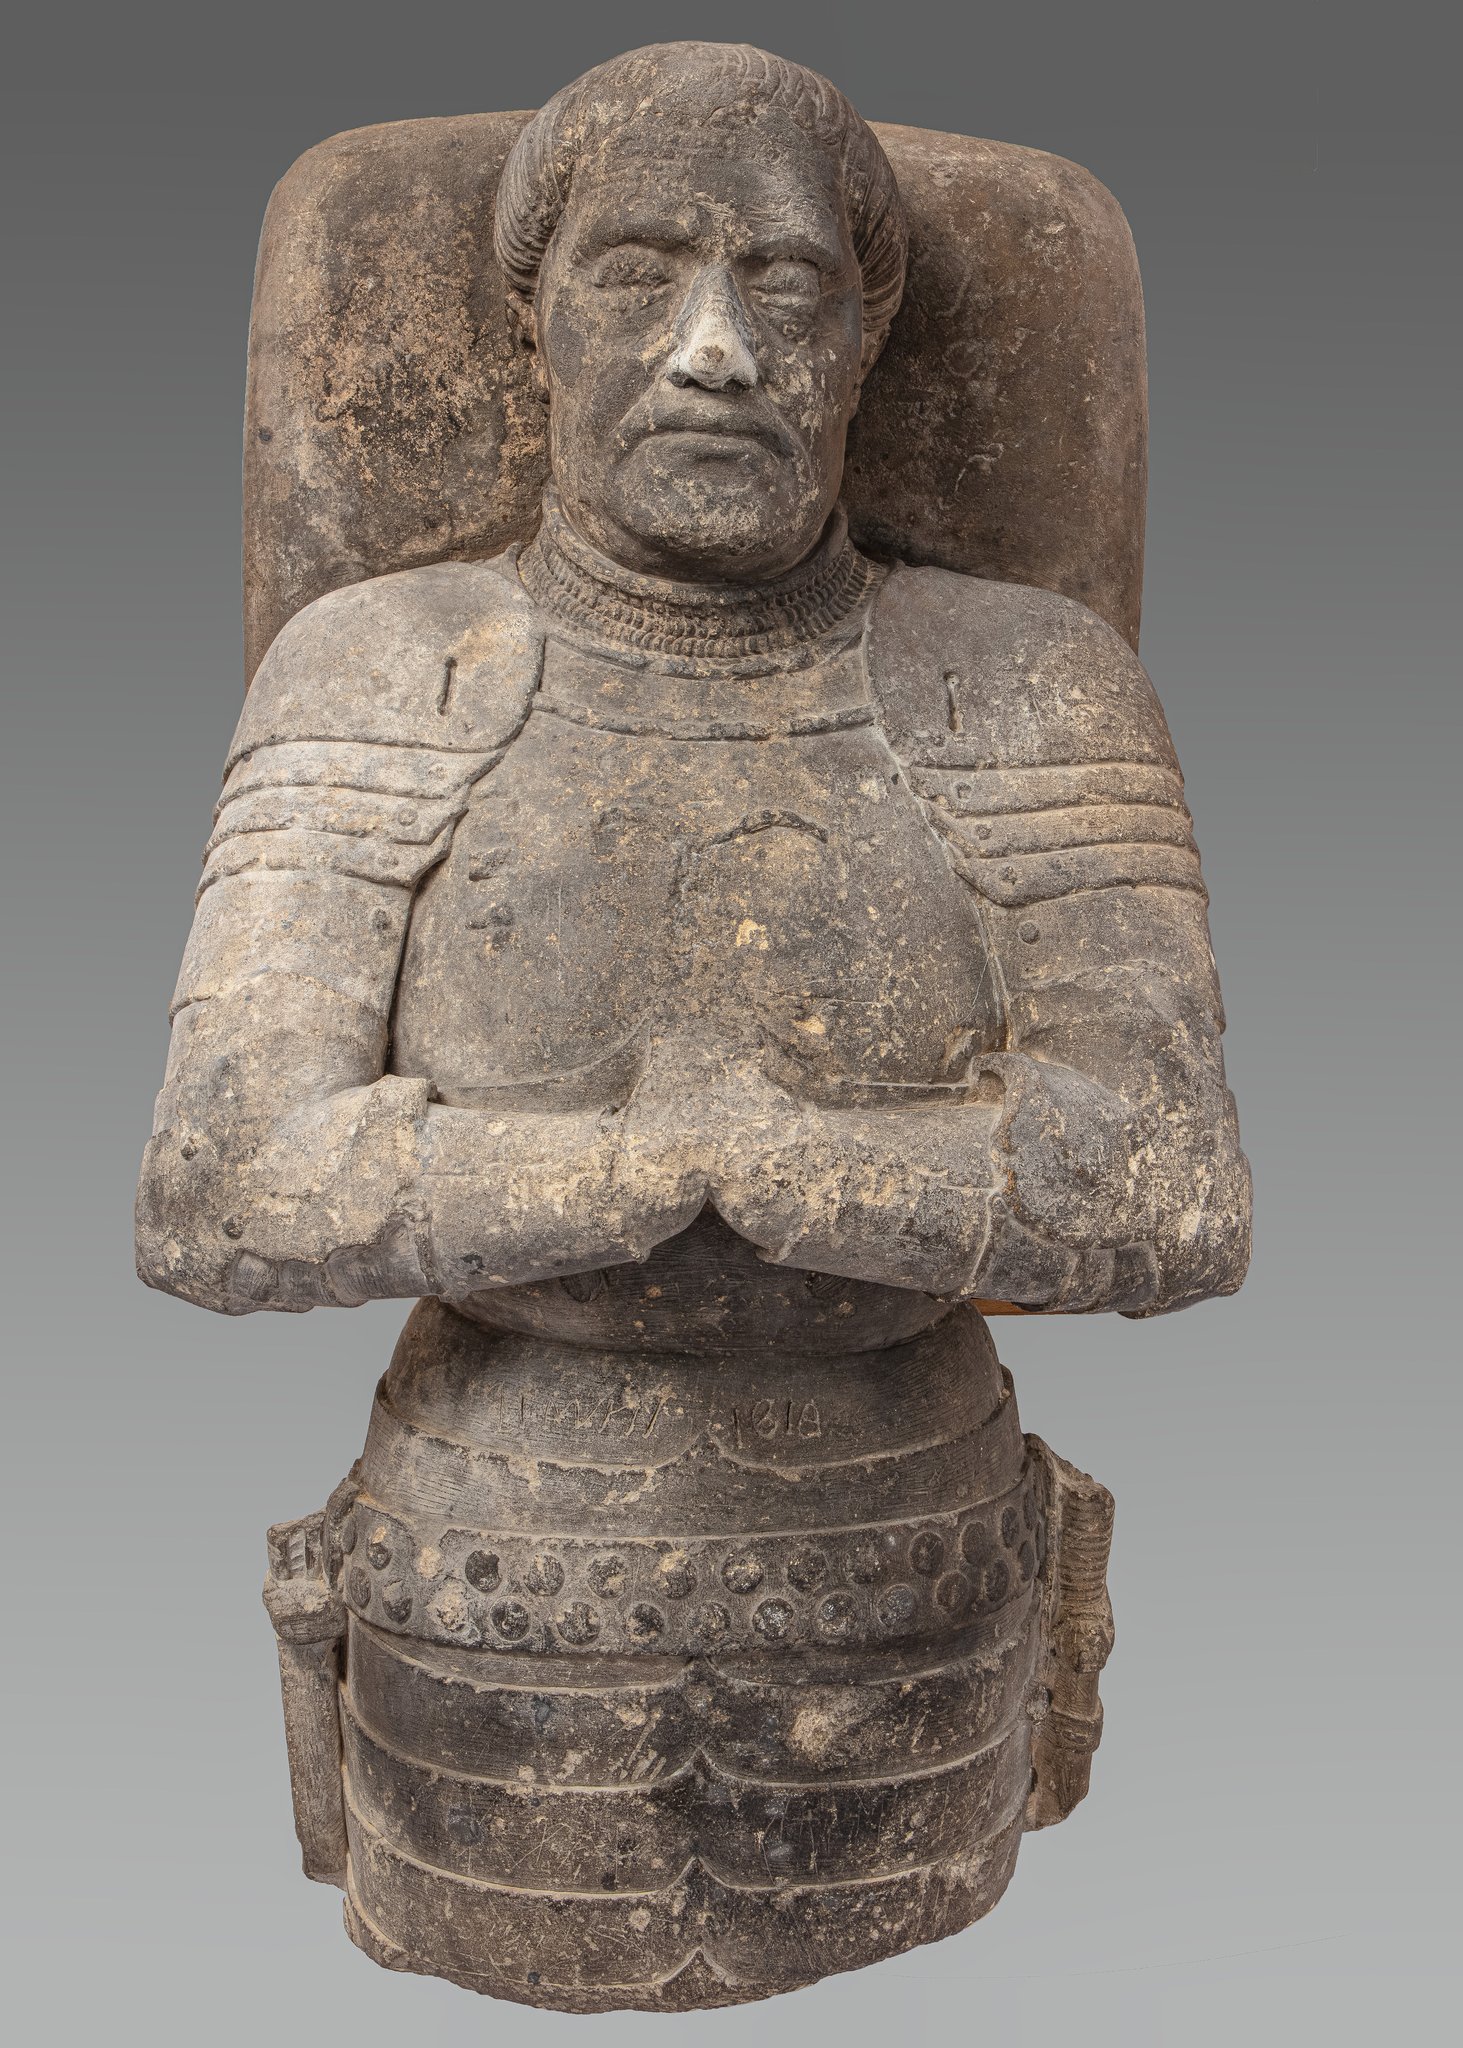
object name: sculpture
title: Tomb Effigy of a Knight in Gothic Armor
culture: french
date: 1425-1450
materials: stone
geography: france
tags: armor,men,knights